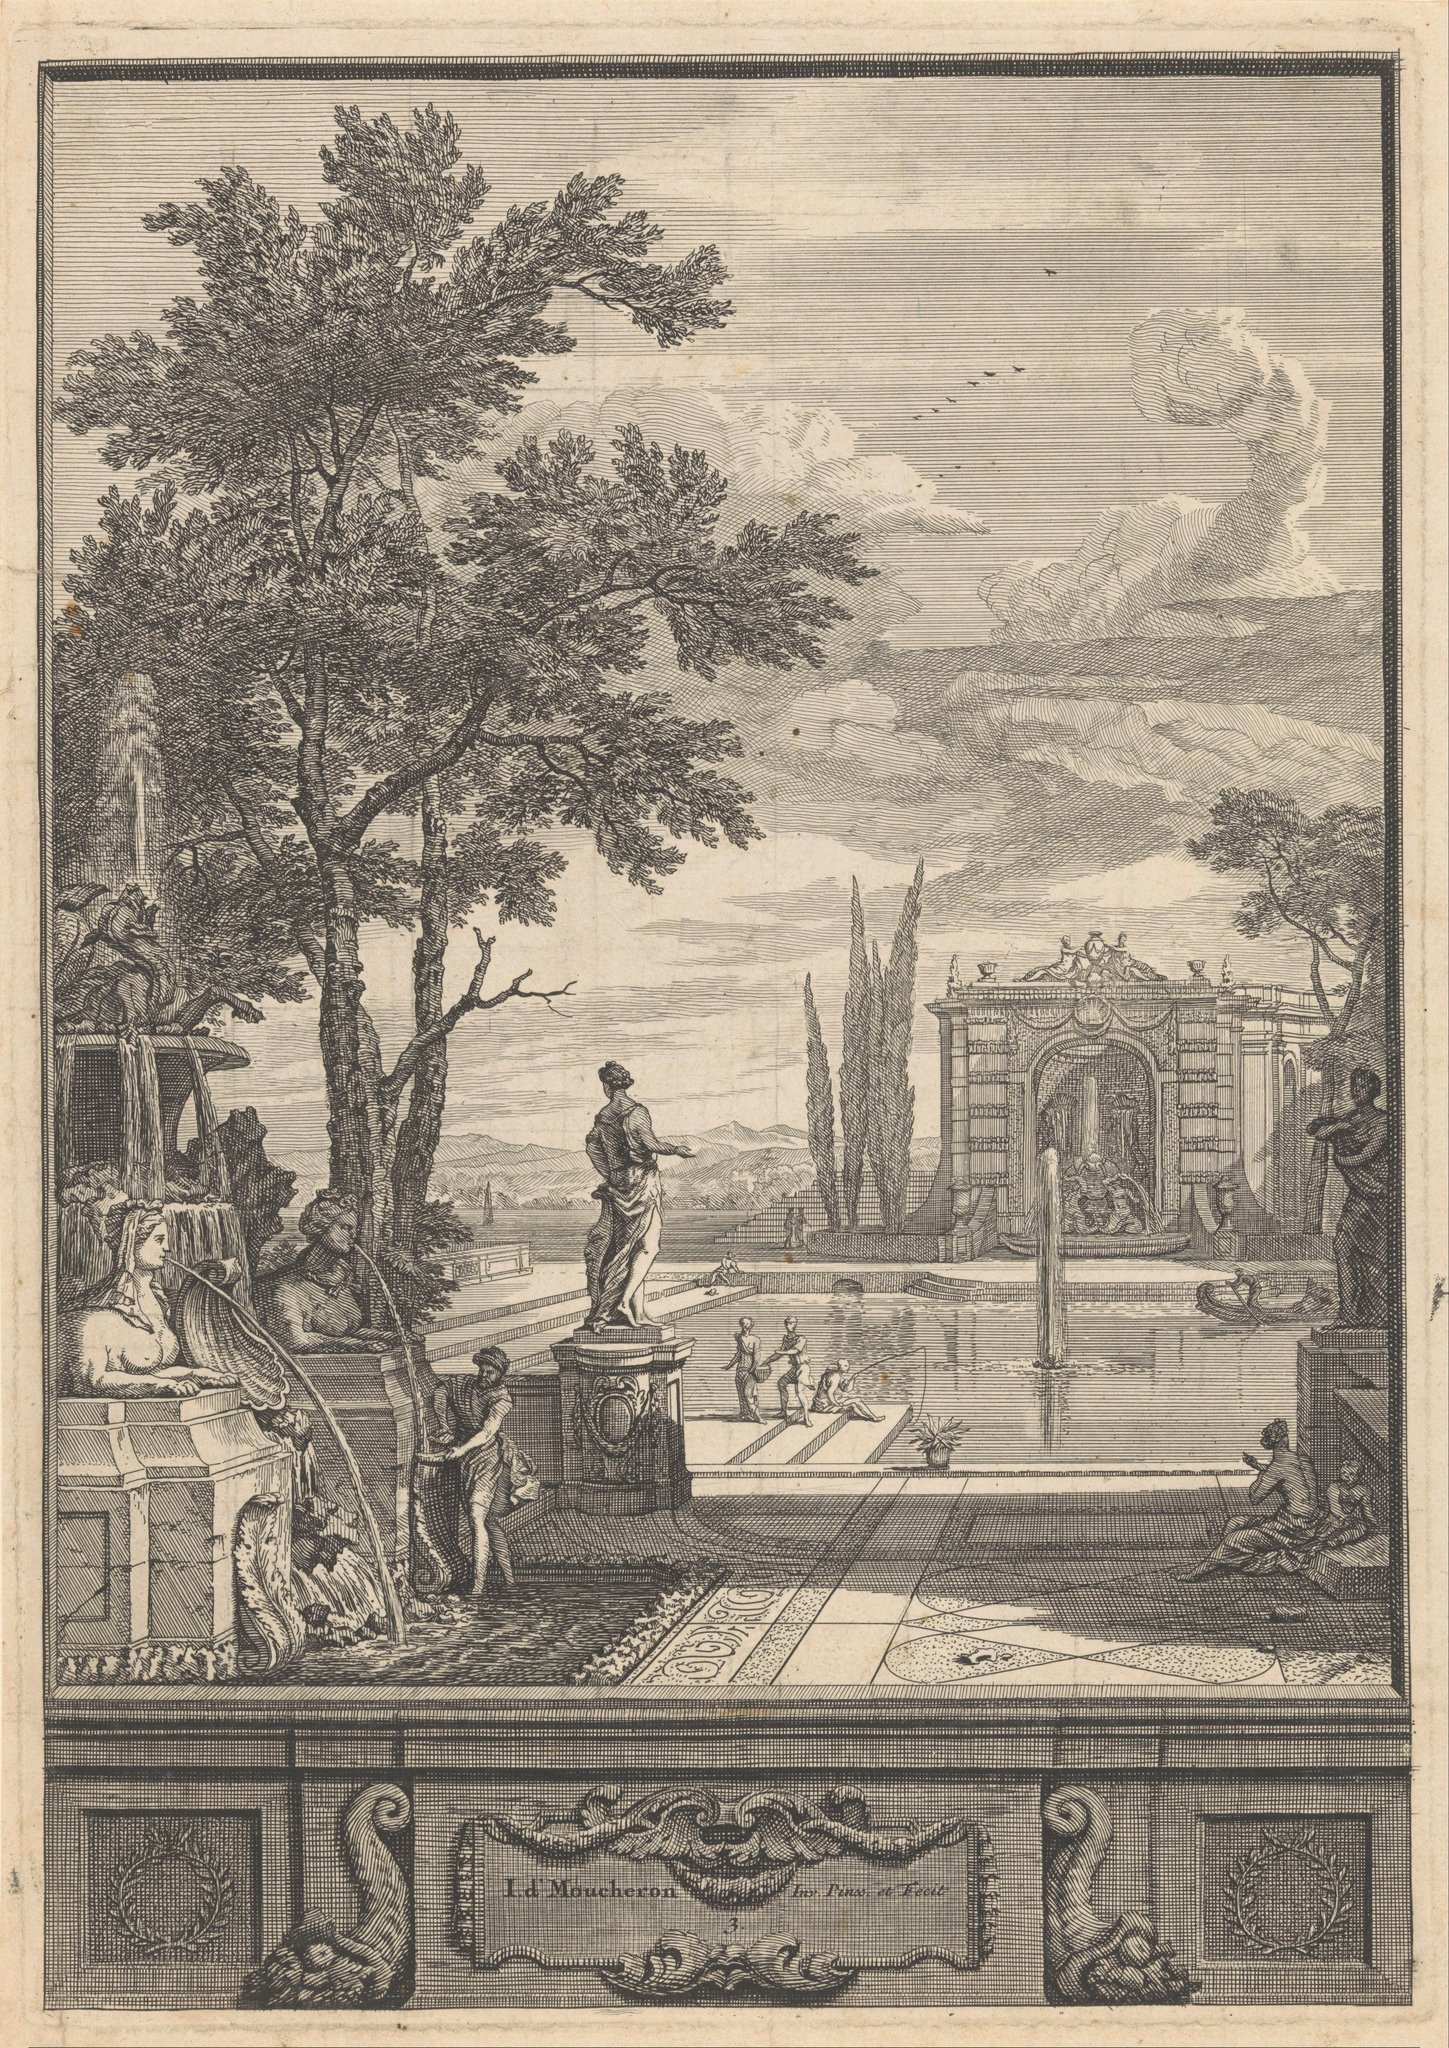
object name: ornament print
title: Zaal-stucken in 't huys van de Hr. D.B. Mezquita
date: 1677-1744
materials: paper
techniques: engraving, etching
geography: amsterdam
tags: ornamental fountain, garden pond, statues, sculptures in garden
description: Landschap met links een fontein met een waterspuwende draak. Aan weerszijden van de draak waterspuwende sfinxen. Op de achtergrond een waterbassin met een gondel. Op de kant figuren en een visser. Naar het beschilderde muurpaneel in de zaal van het huis van koopman David Bueno de Mesquita.